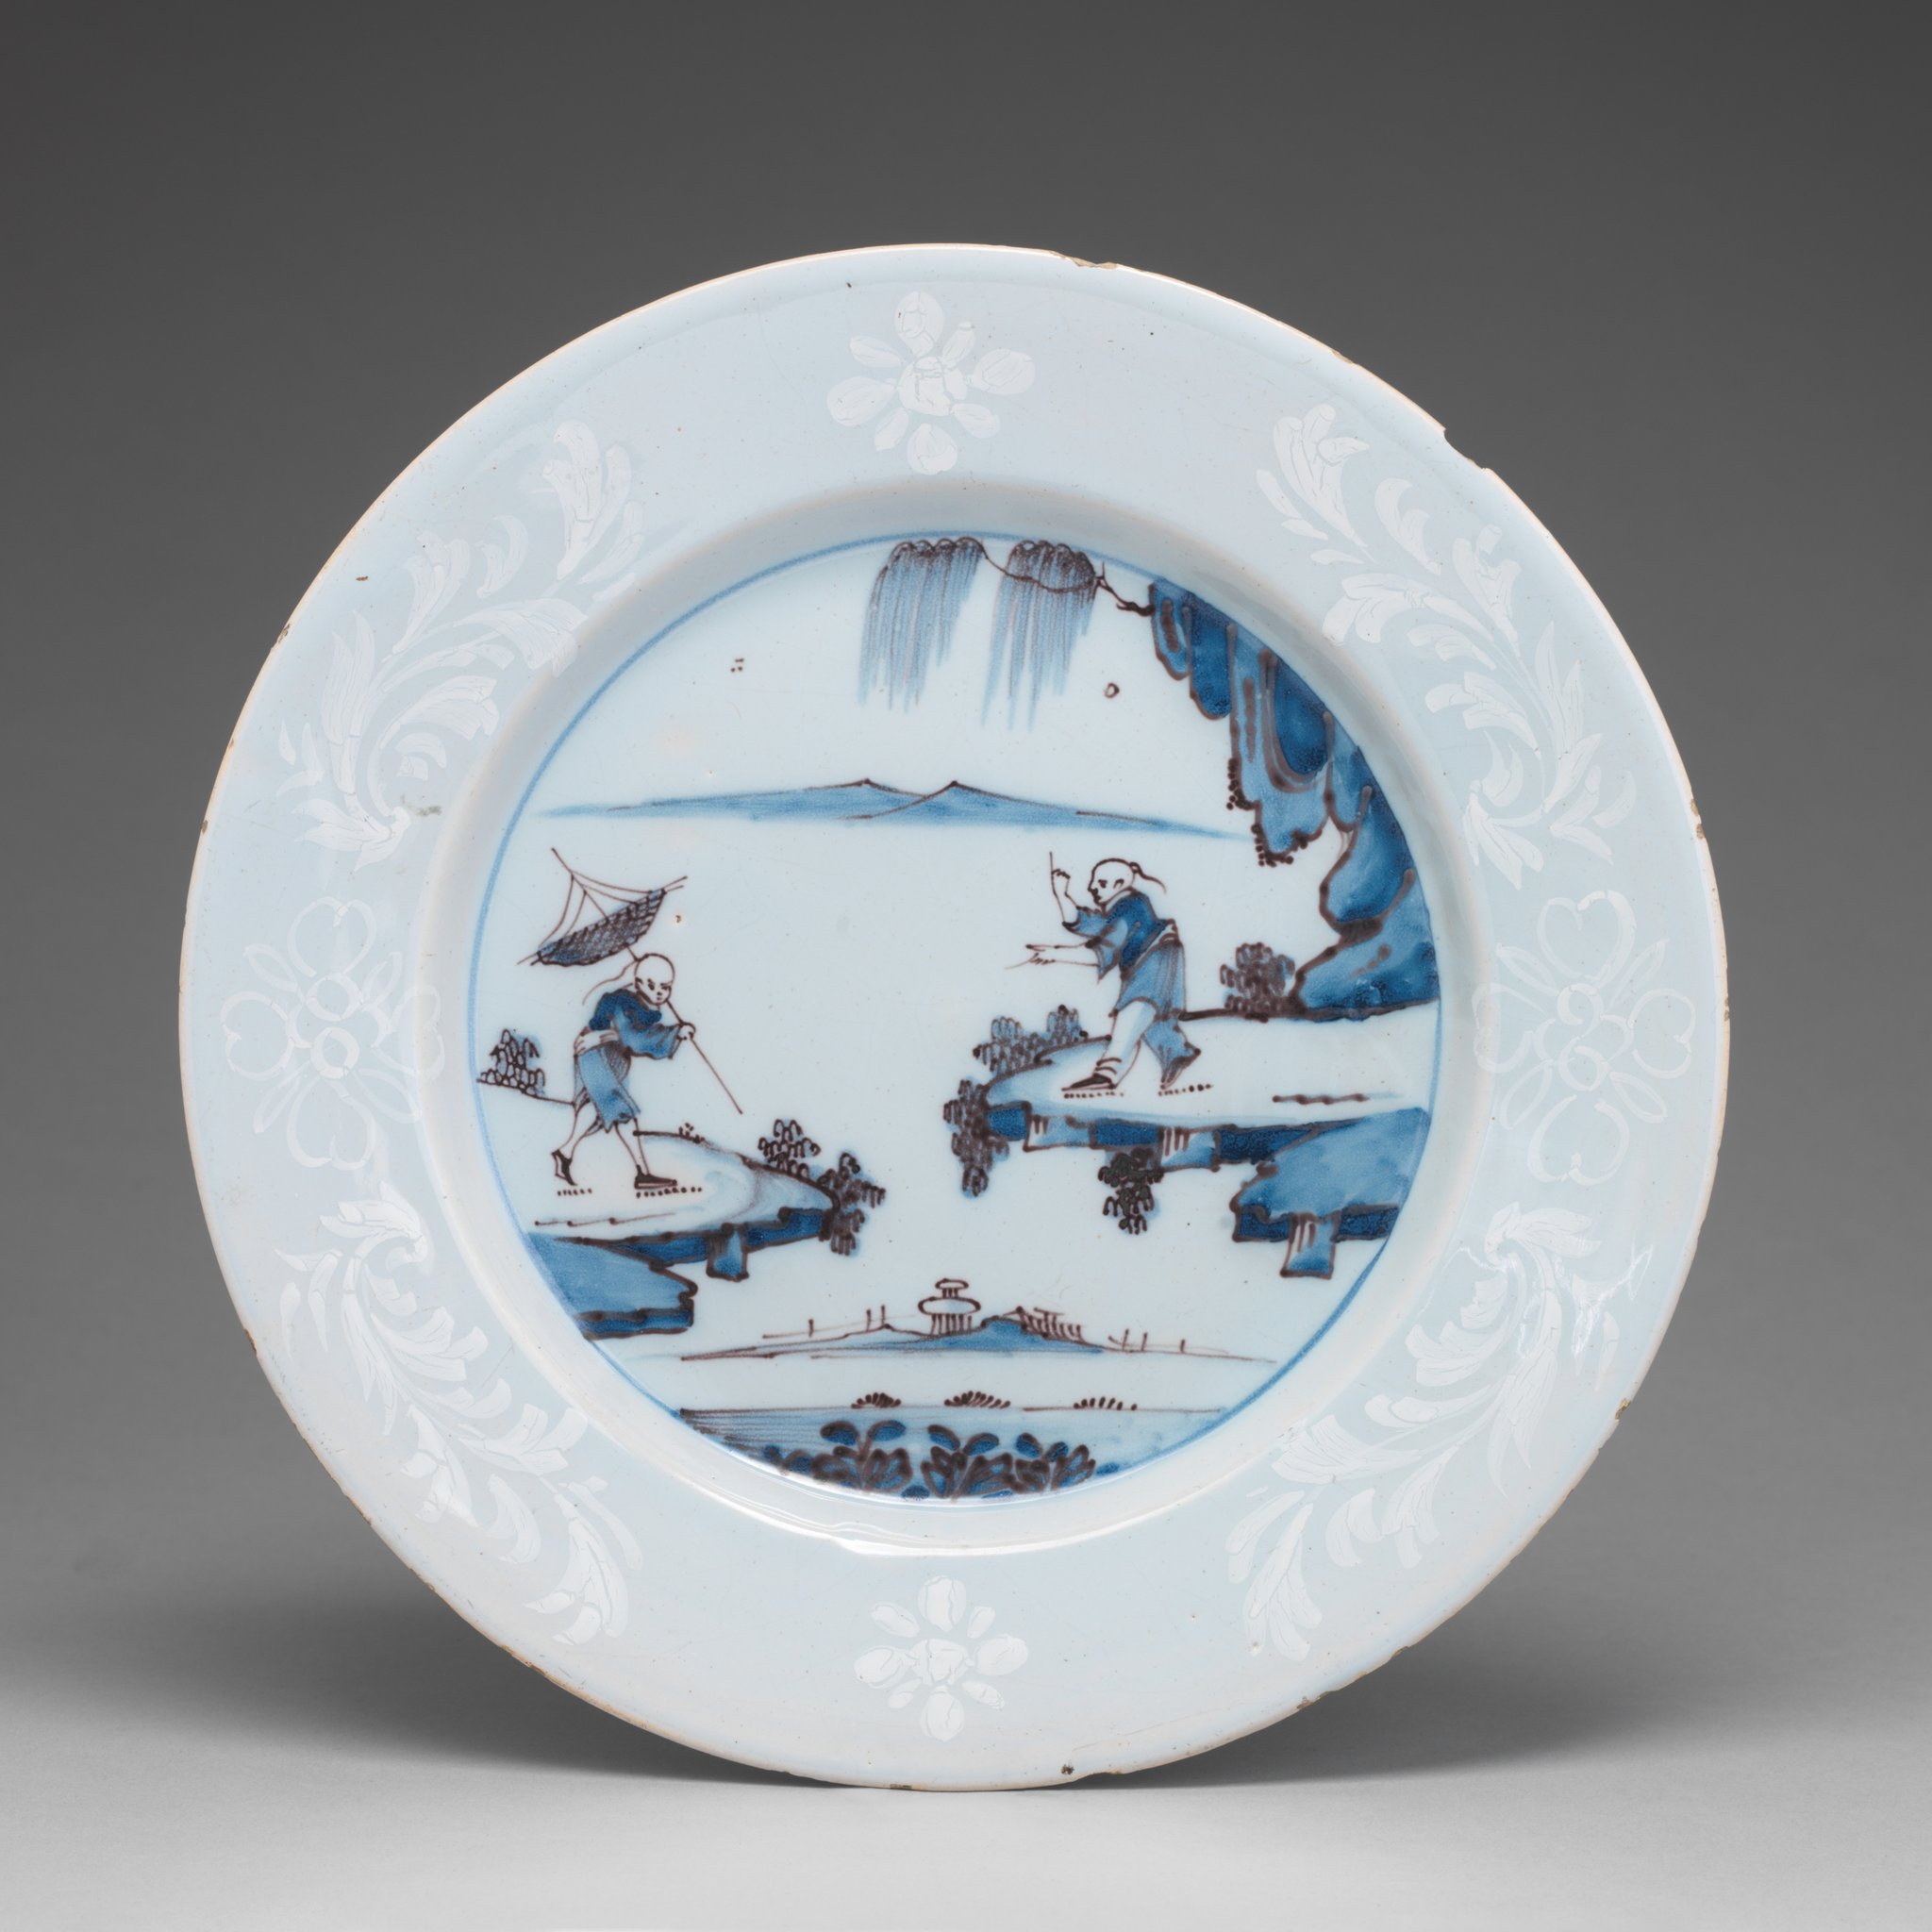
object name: plate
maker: joseph flower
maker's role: maker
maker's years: 1700-1800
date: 1750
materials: earthenware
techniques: glazing